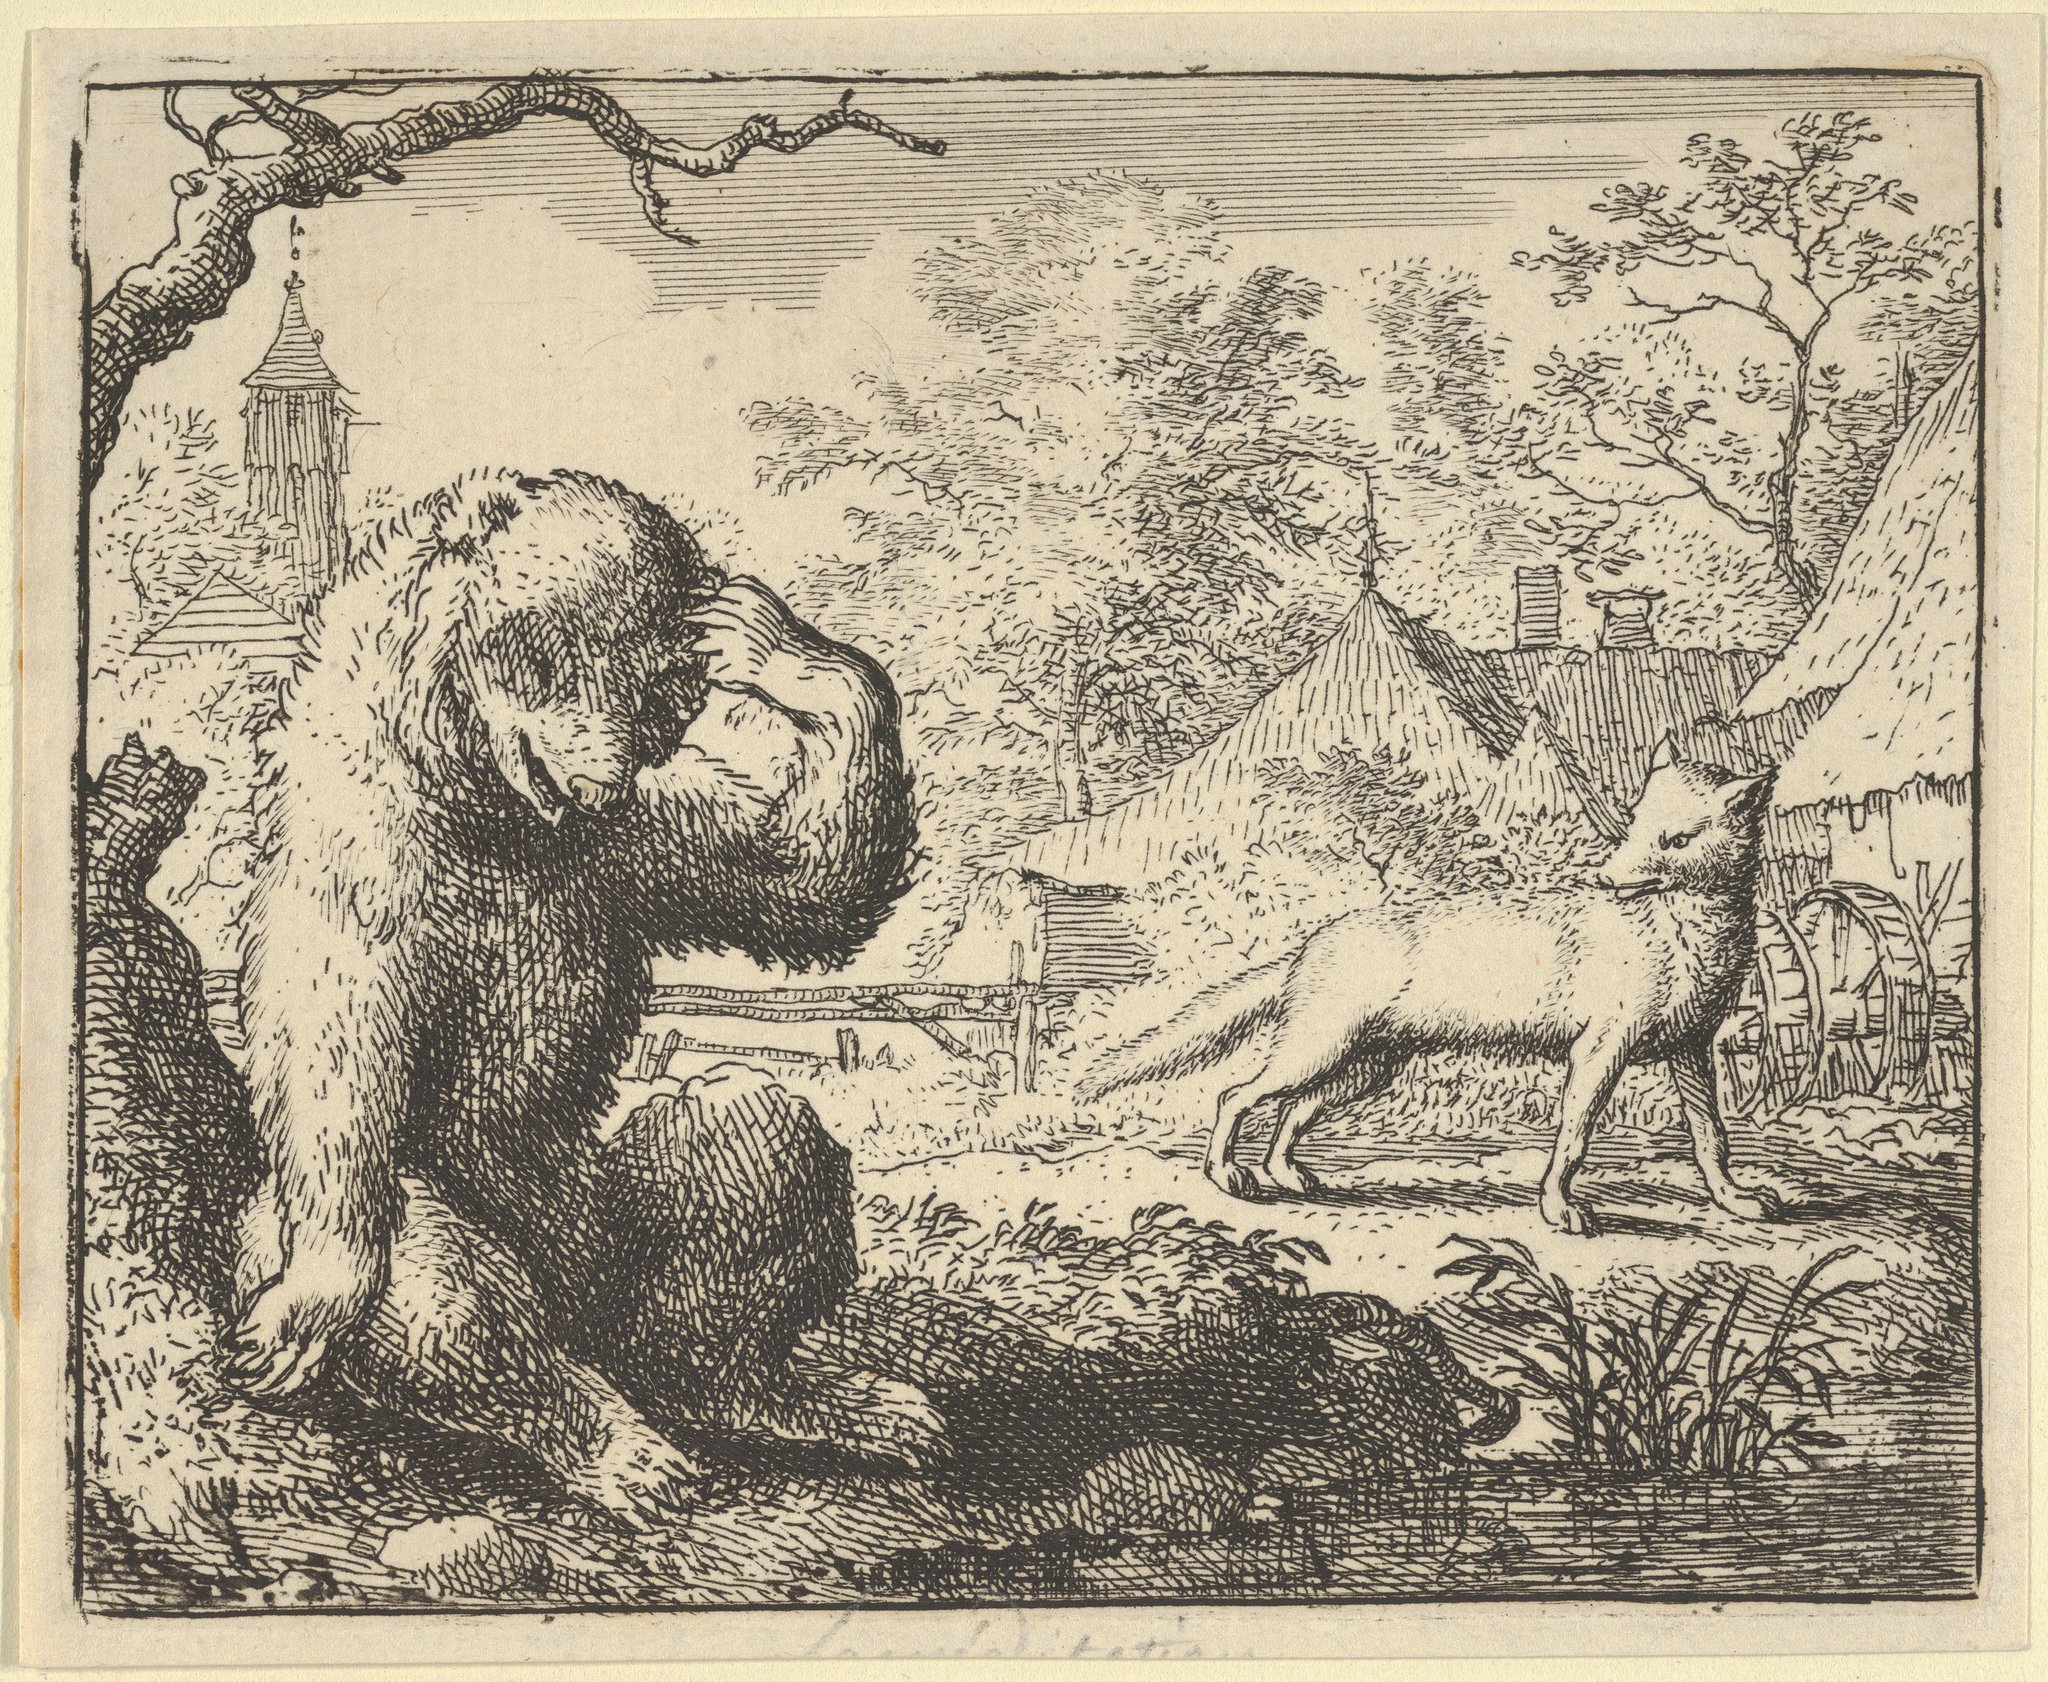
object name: print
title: Renard Makes Fun of the Bear from Hendrick van Alcmar's Renard The Fox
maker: allart van everdingen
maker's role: artist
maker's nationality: dutch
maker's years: 1621-1675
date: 1650-1675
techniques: engraving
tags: bears,foxes